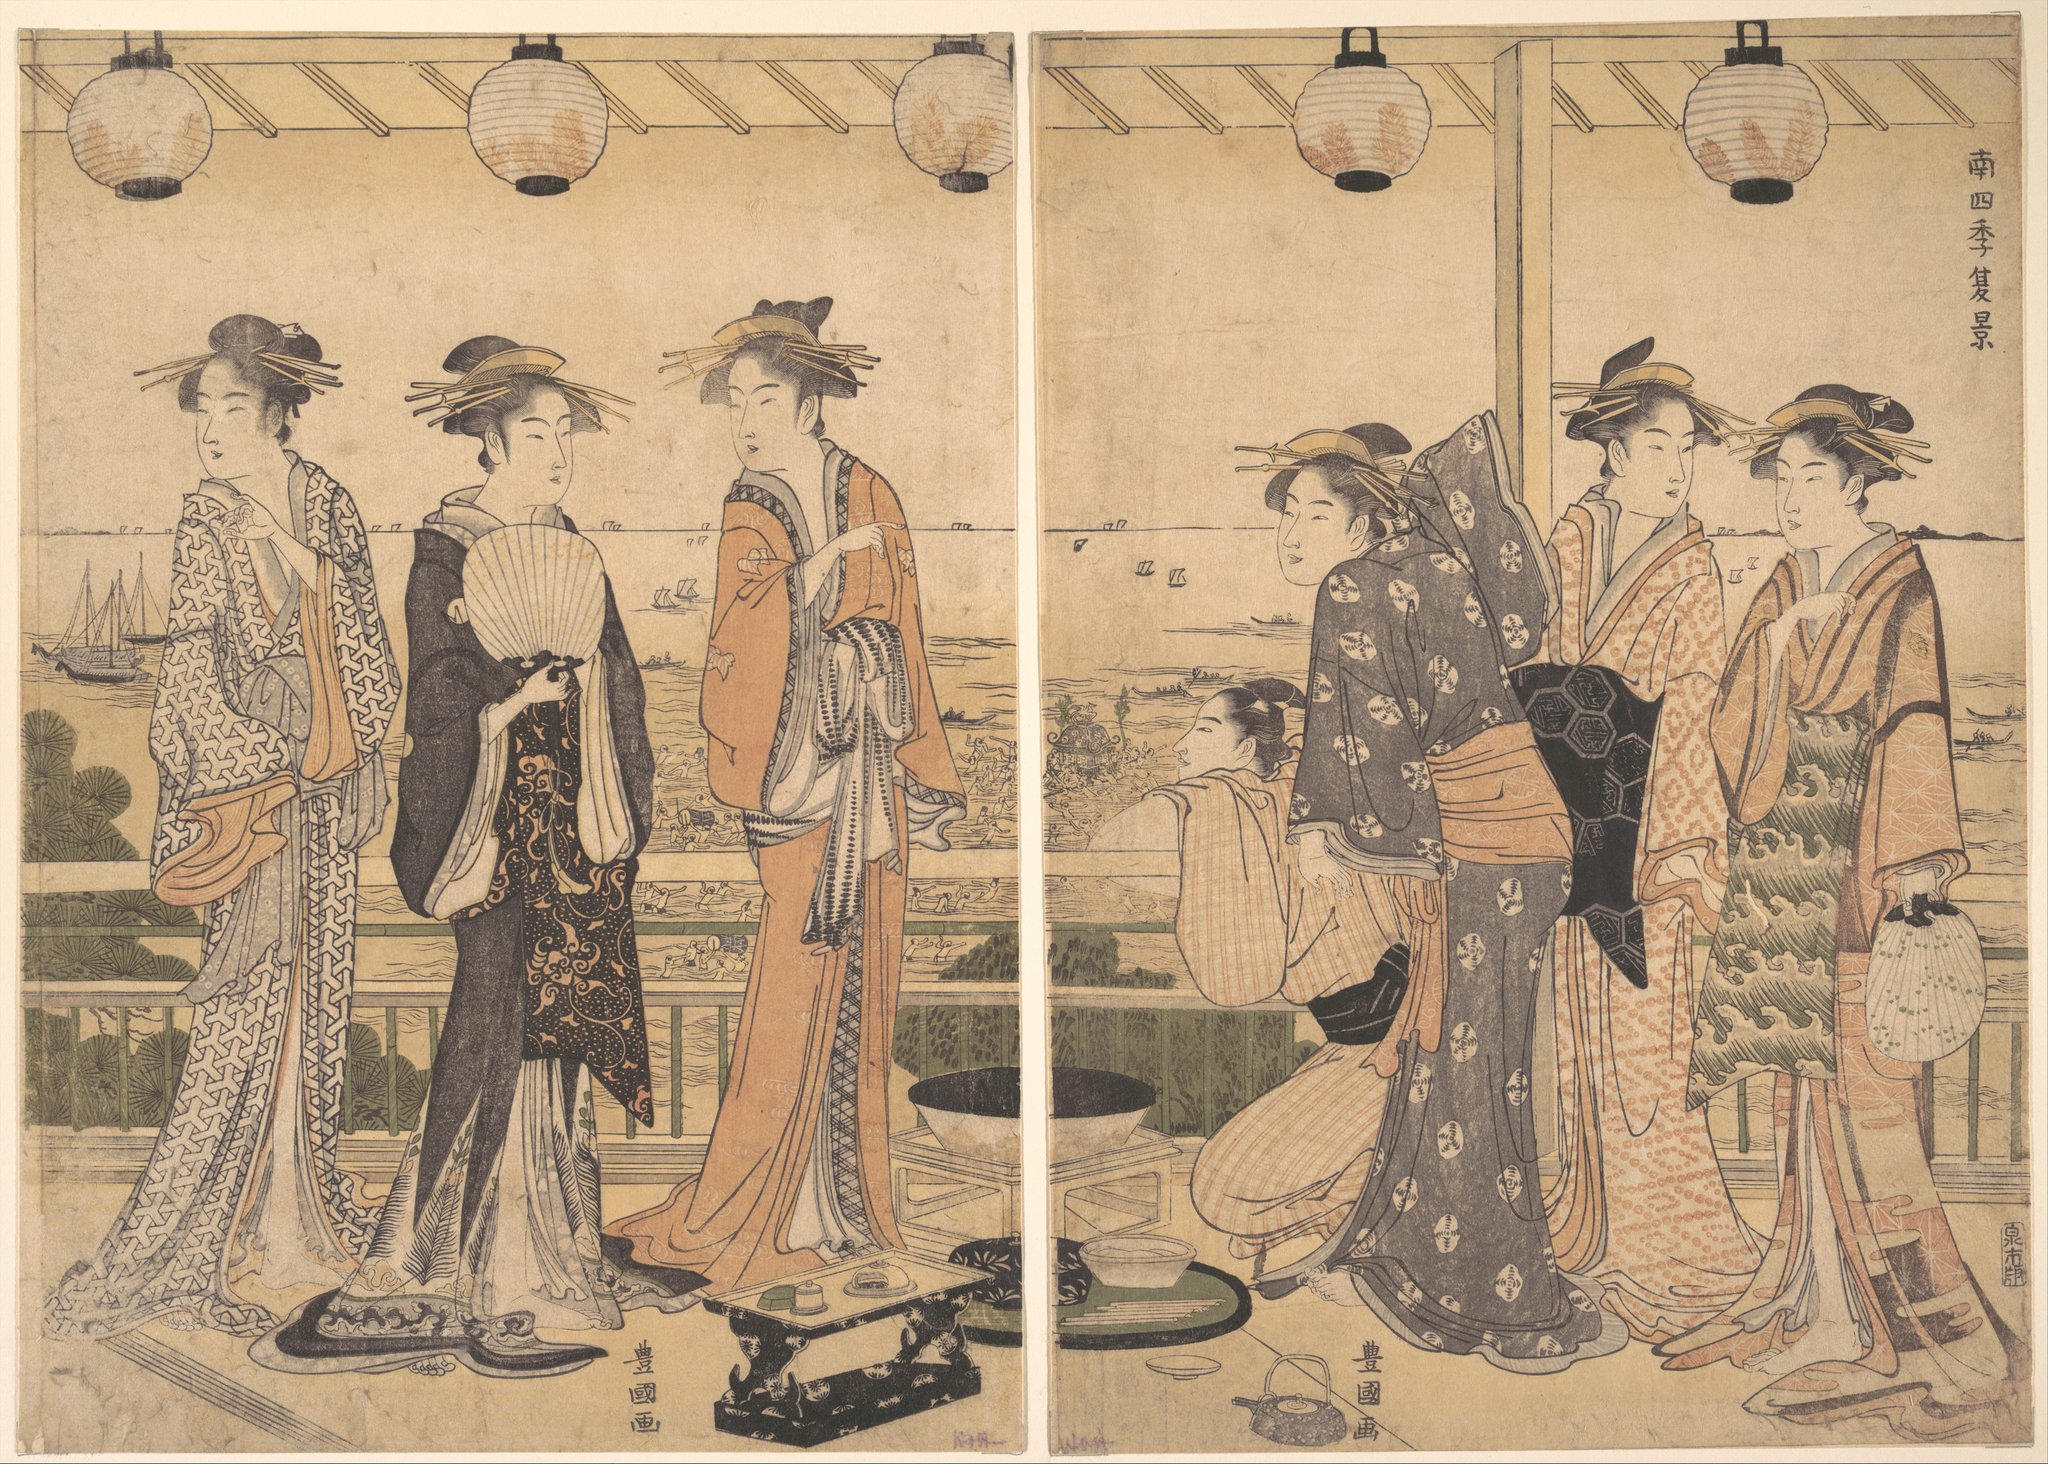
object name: print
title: The Four Seasons in Southern Edo: A Summer Scene (Minami shiki; Natsu [no] kei)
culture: japanese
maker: utagawa toyokuni i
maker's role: artist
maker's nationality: japanese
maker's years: 1769-1825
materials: ink, paper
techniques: woodblock print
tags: fans,women,summer